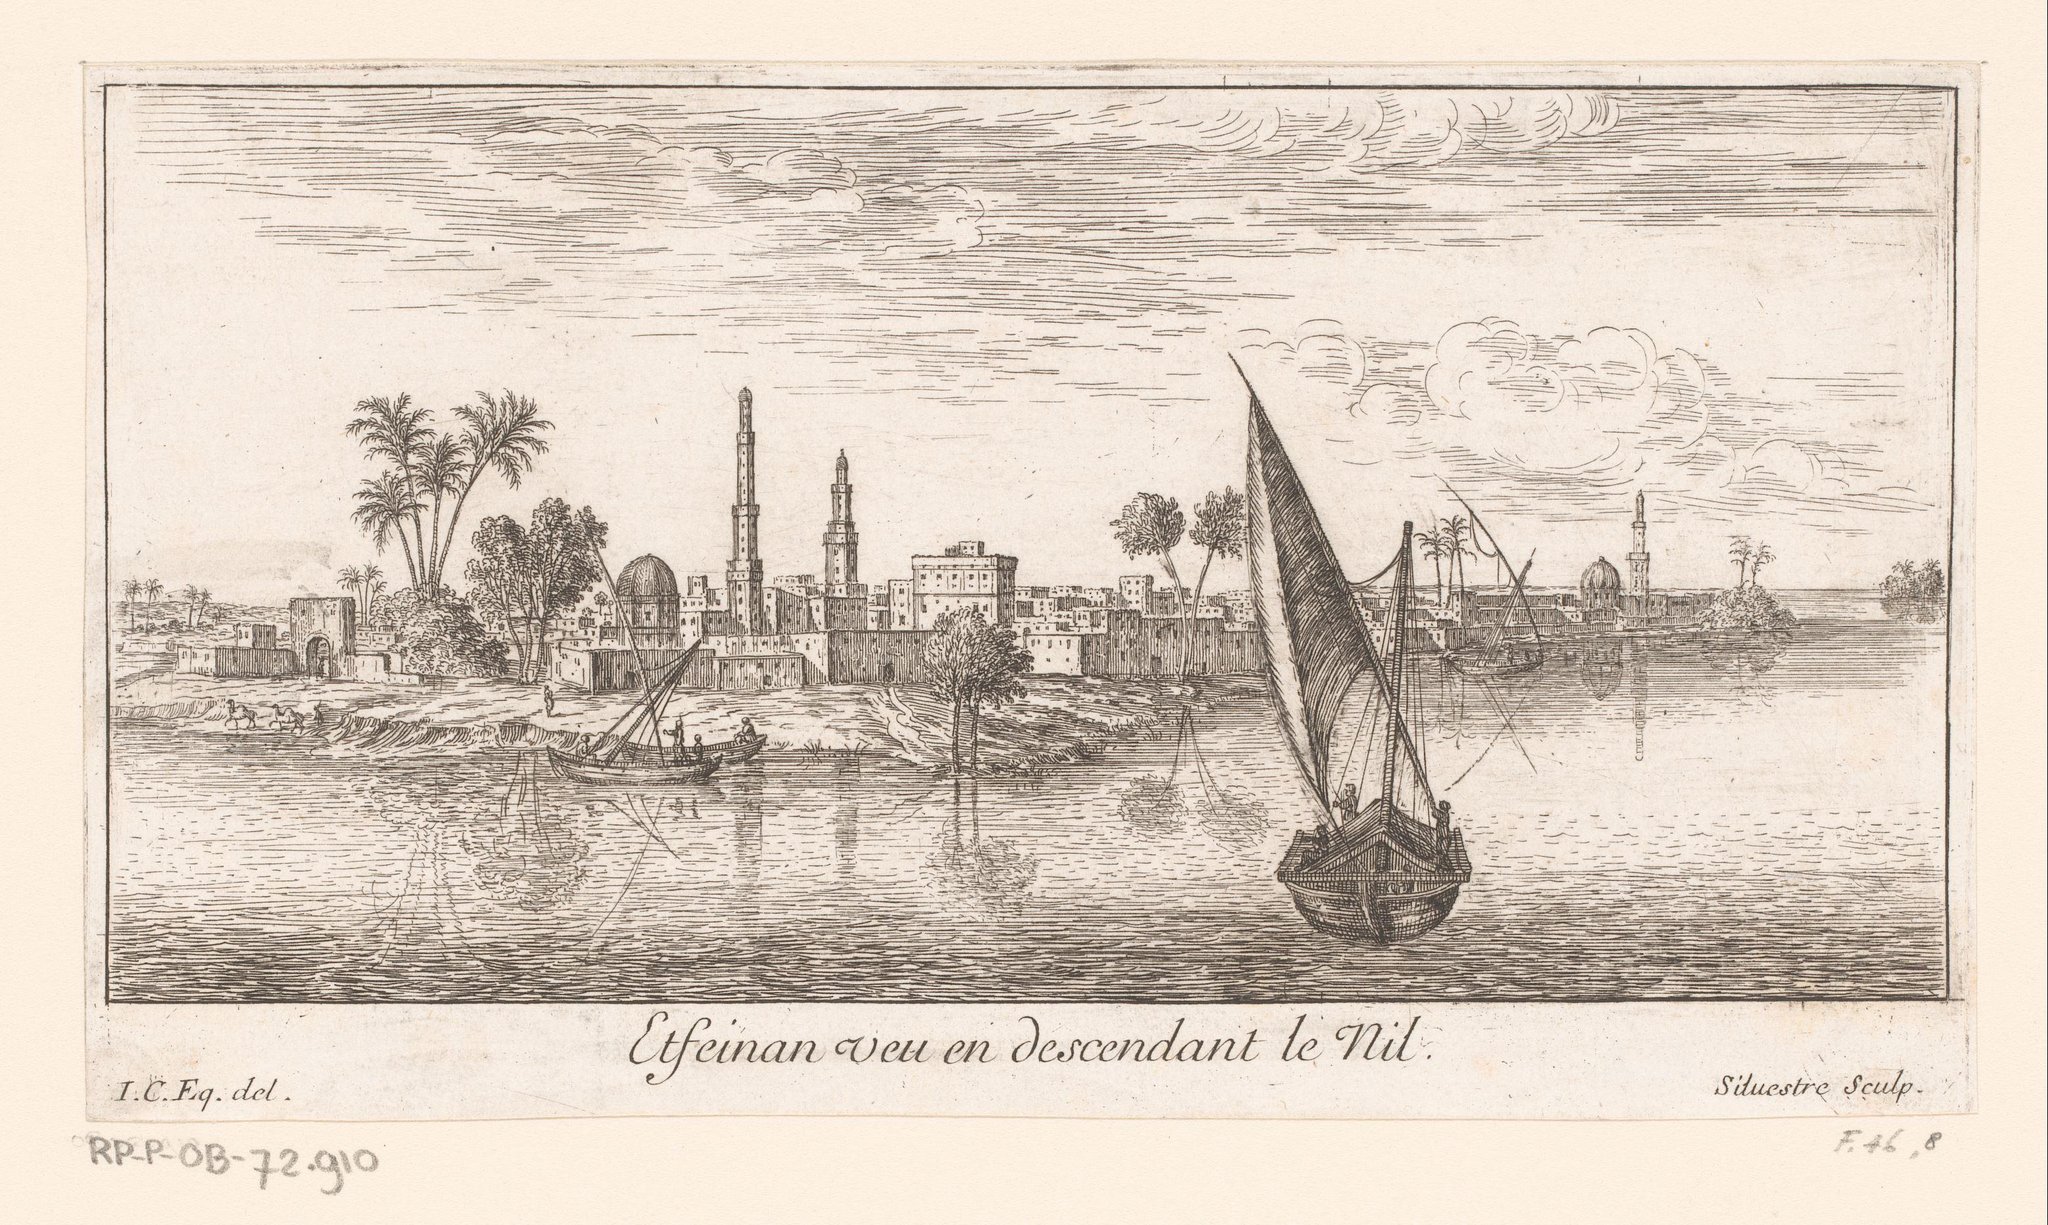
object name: print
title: Etfeinan veu en descendant le Nil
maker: israël silvestre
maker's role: draughtsman, print maker, publisher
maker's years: 1621-1691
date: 1631-1691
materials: paper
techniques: etching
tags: city-view in general; 'veduta'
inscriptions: collector's mark: Lugt 240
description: Prent maakt deel uit van een ongenummerde serie van tien prenten.